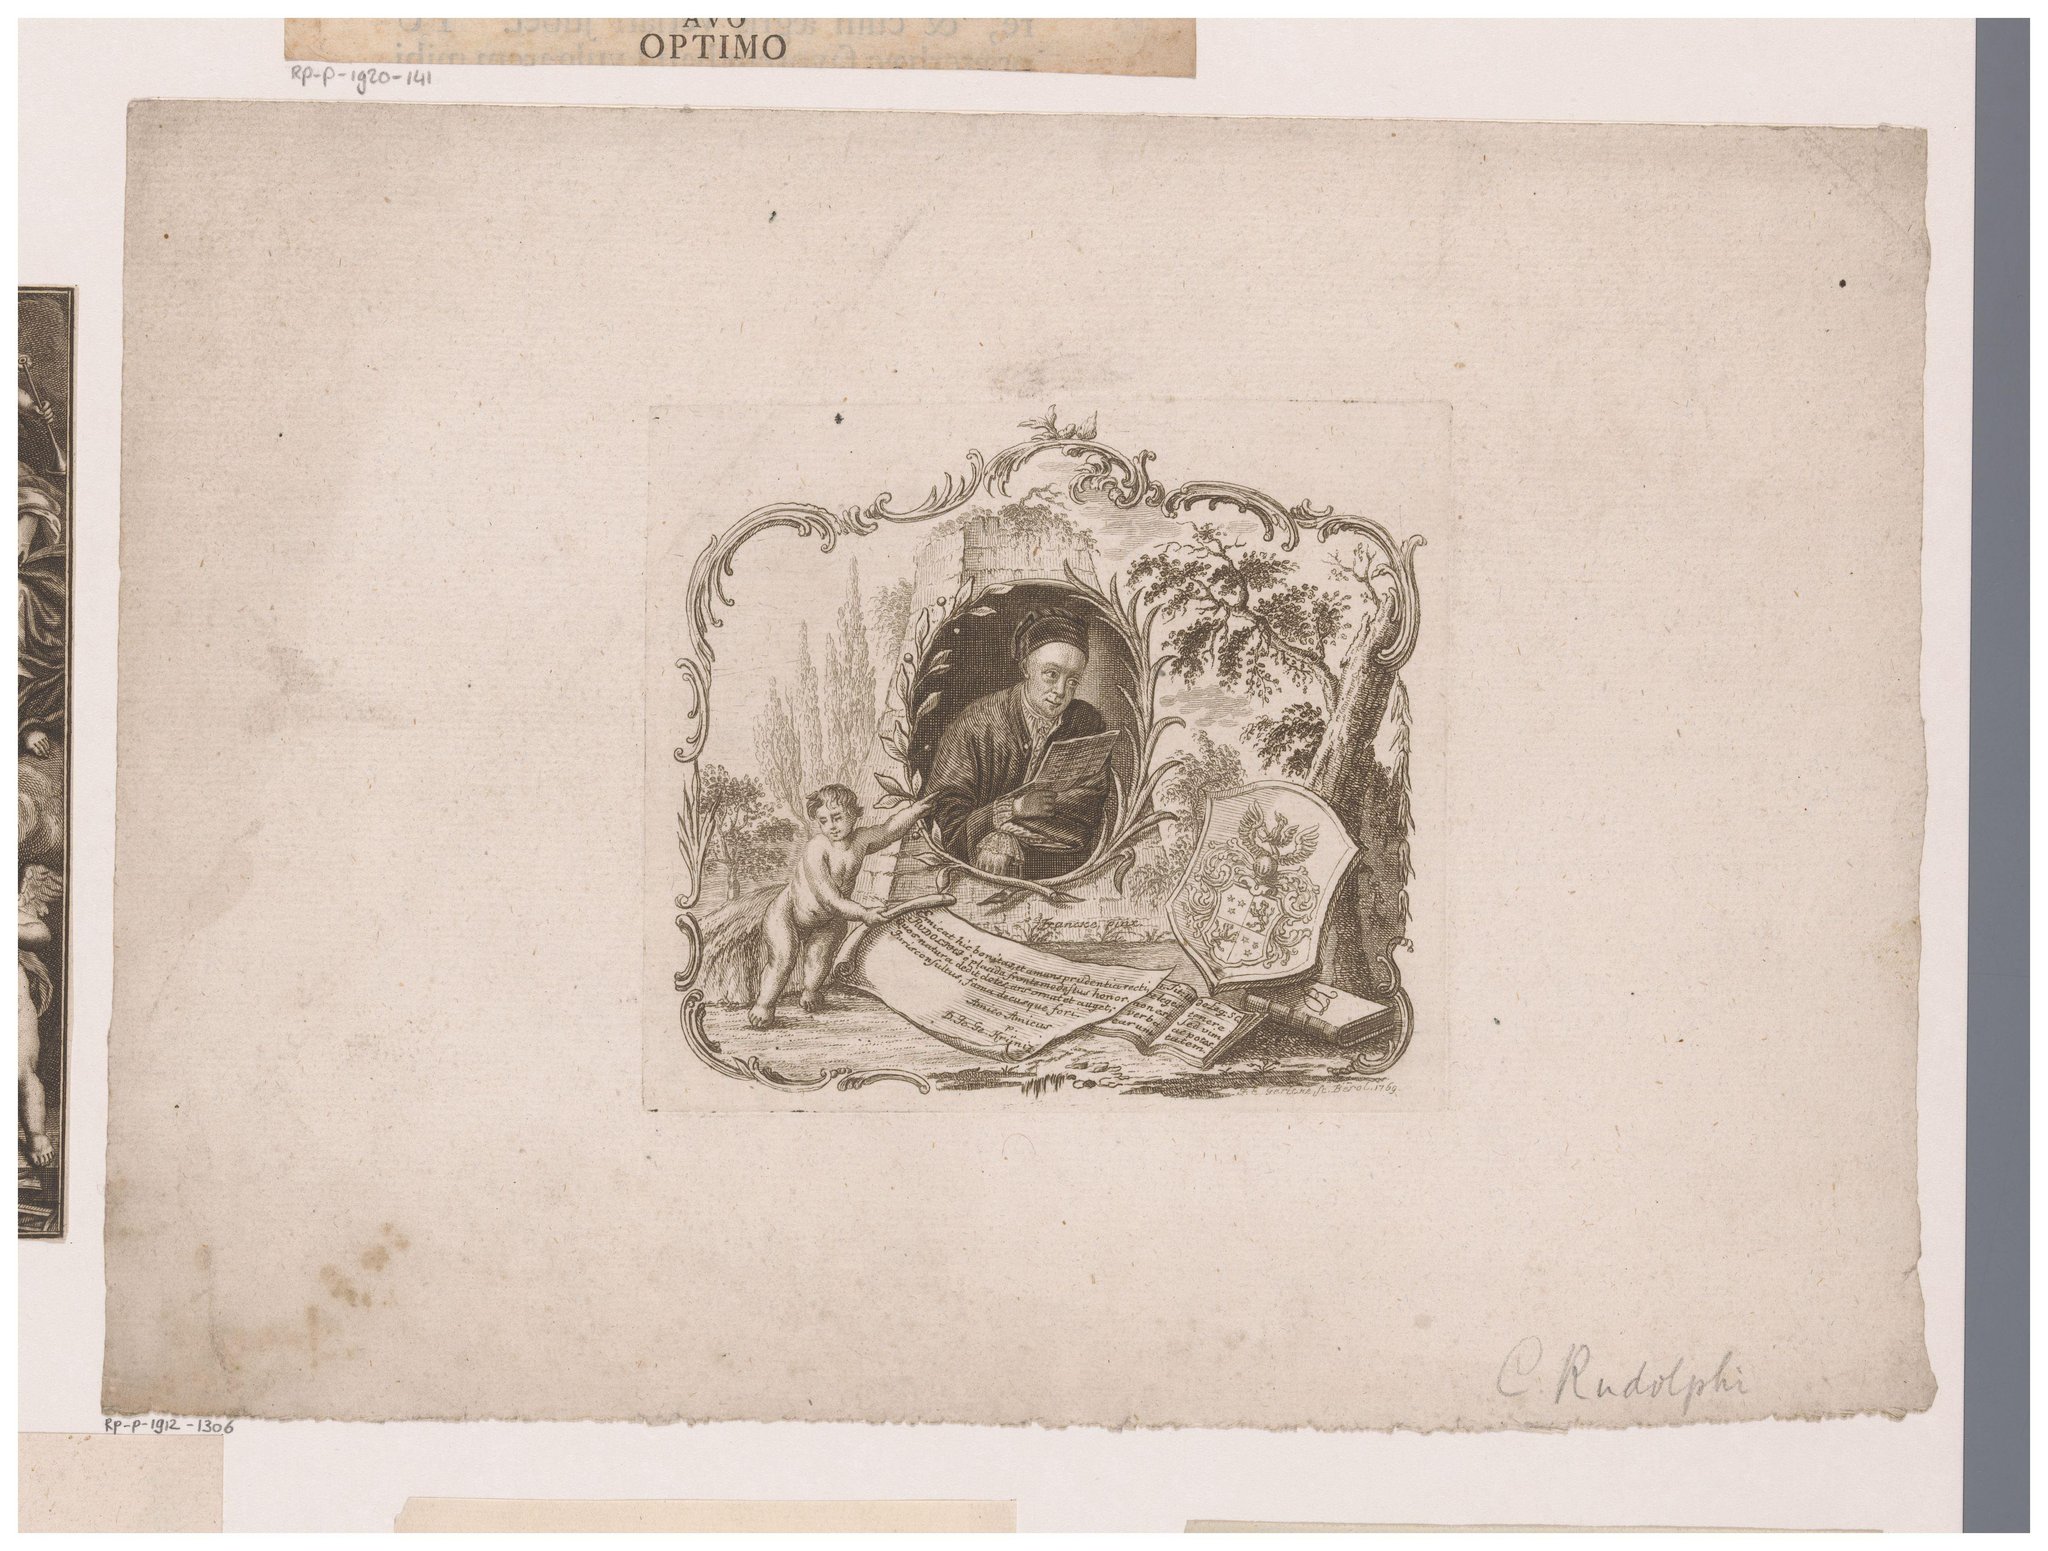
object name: print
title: Portret van C. Rudolphi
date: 1769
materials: paper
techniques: etching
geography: berlin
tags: plants; vegetation, trees: palm-tree (+ branch, stick), rocaille ornament, historical persons, cupids: 'amores', 'amoretti', 'putti', armorial bearing, heraldry, trees: olive-tree (+ branch, stick)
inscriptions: collector's mark: Lugt 2228